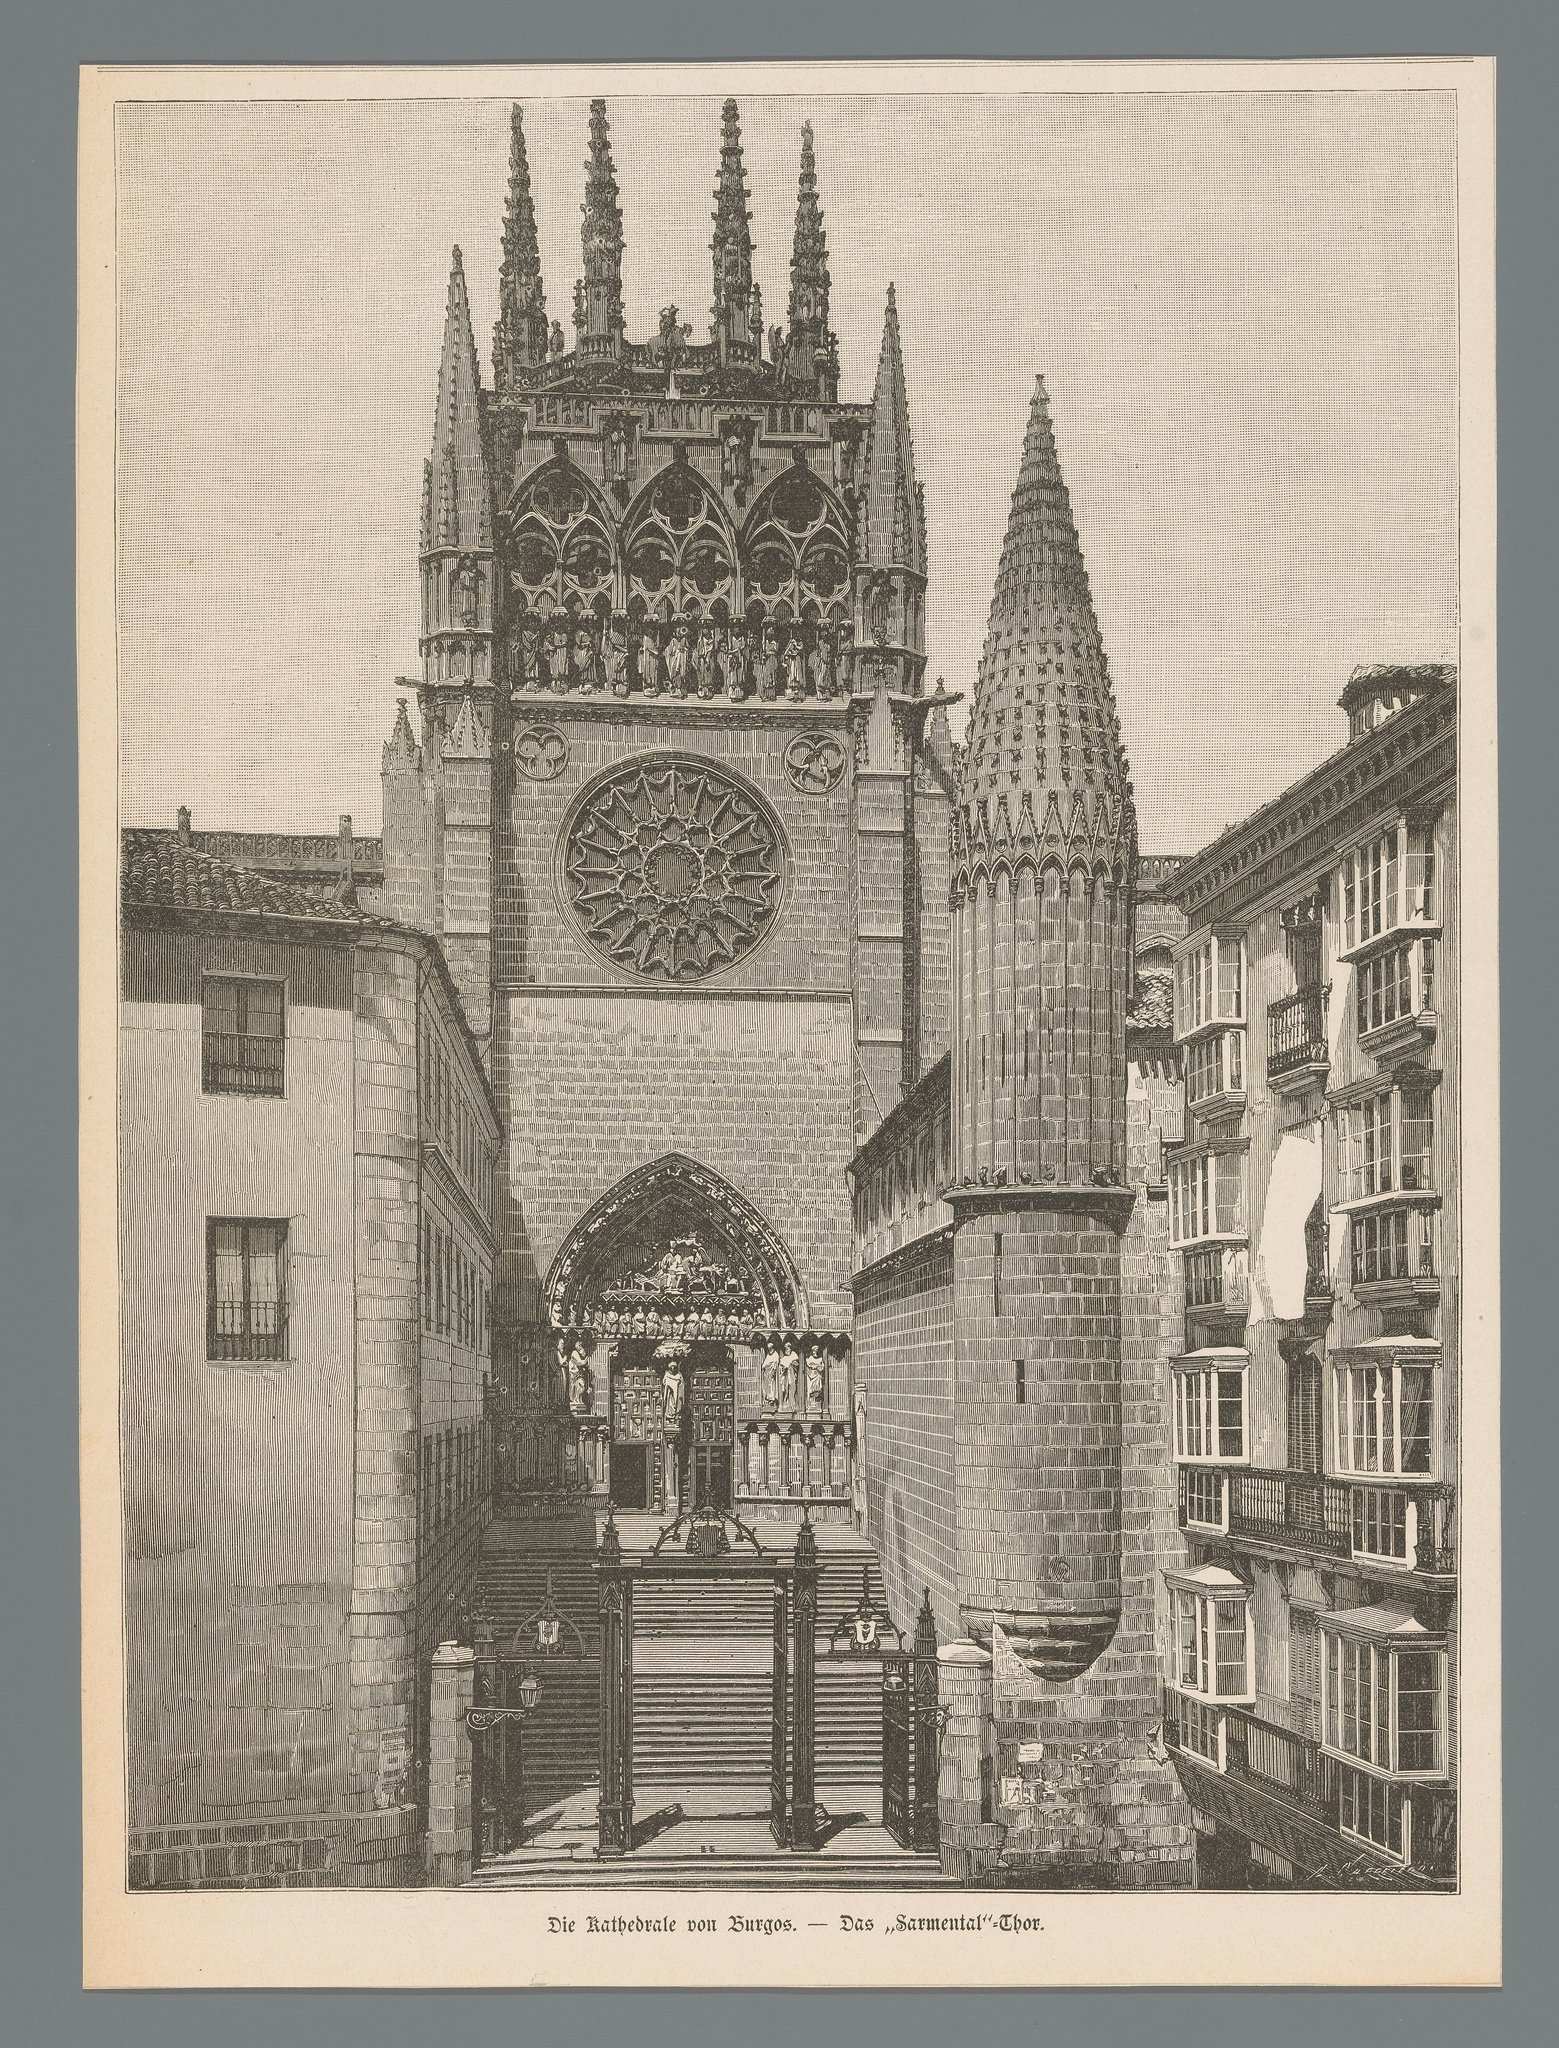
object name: print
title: Gezicht op de Puerta del Sarmental in de kathedraal van Burgos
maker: Anonymous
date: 1850-1900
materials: paper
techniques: letterpress printing, engraving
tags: parts of church exterior and annexes: portal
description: Deze prent maakt deel uit van een album.